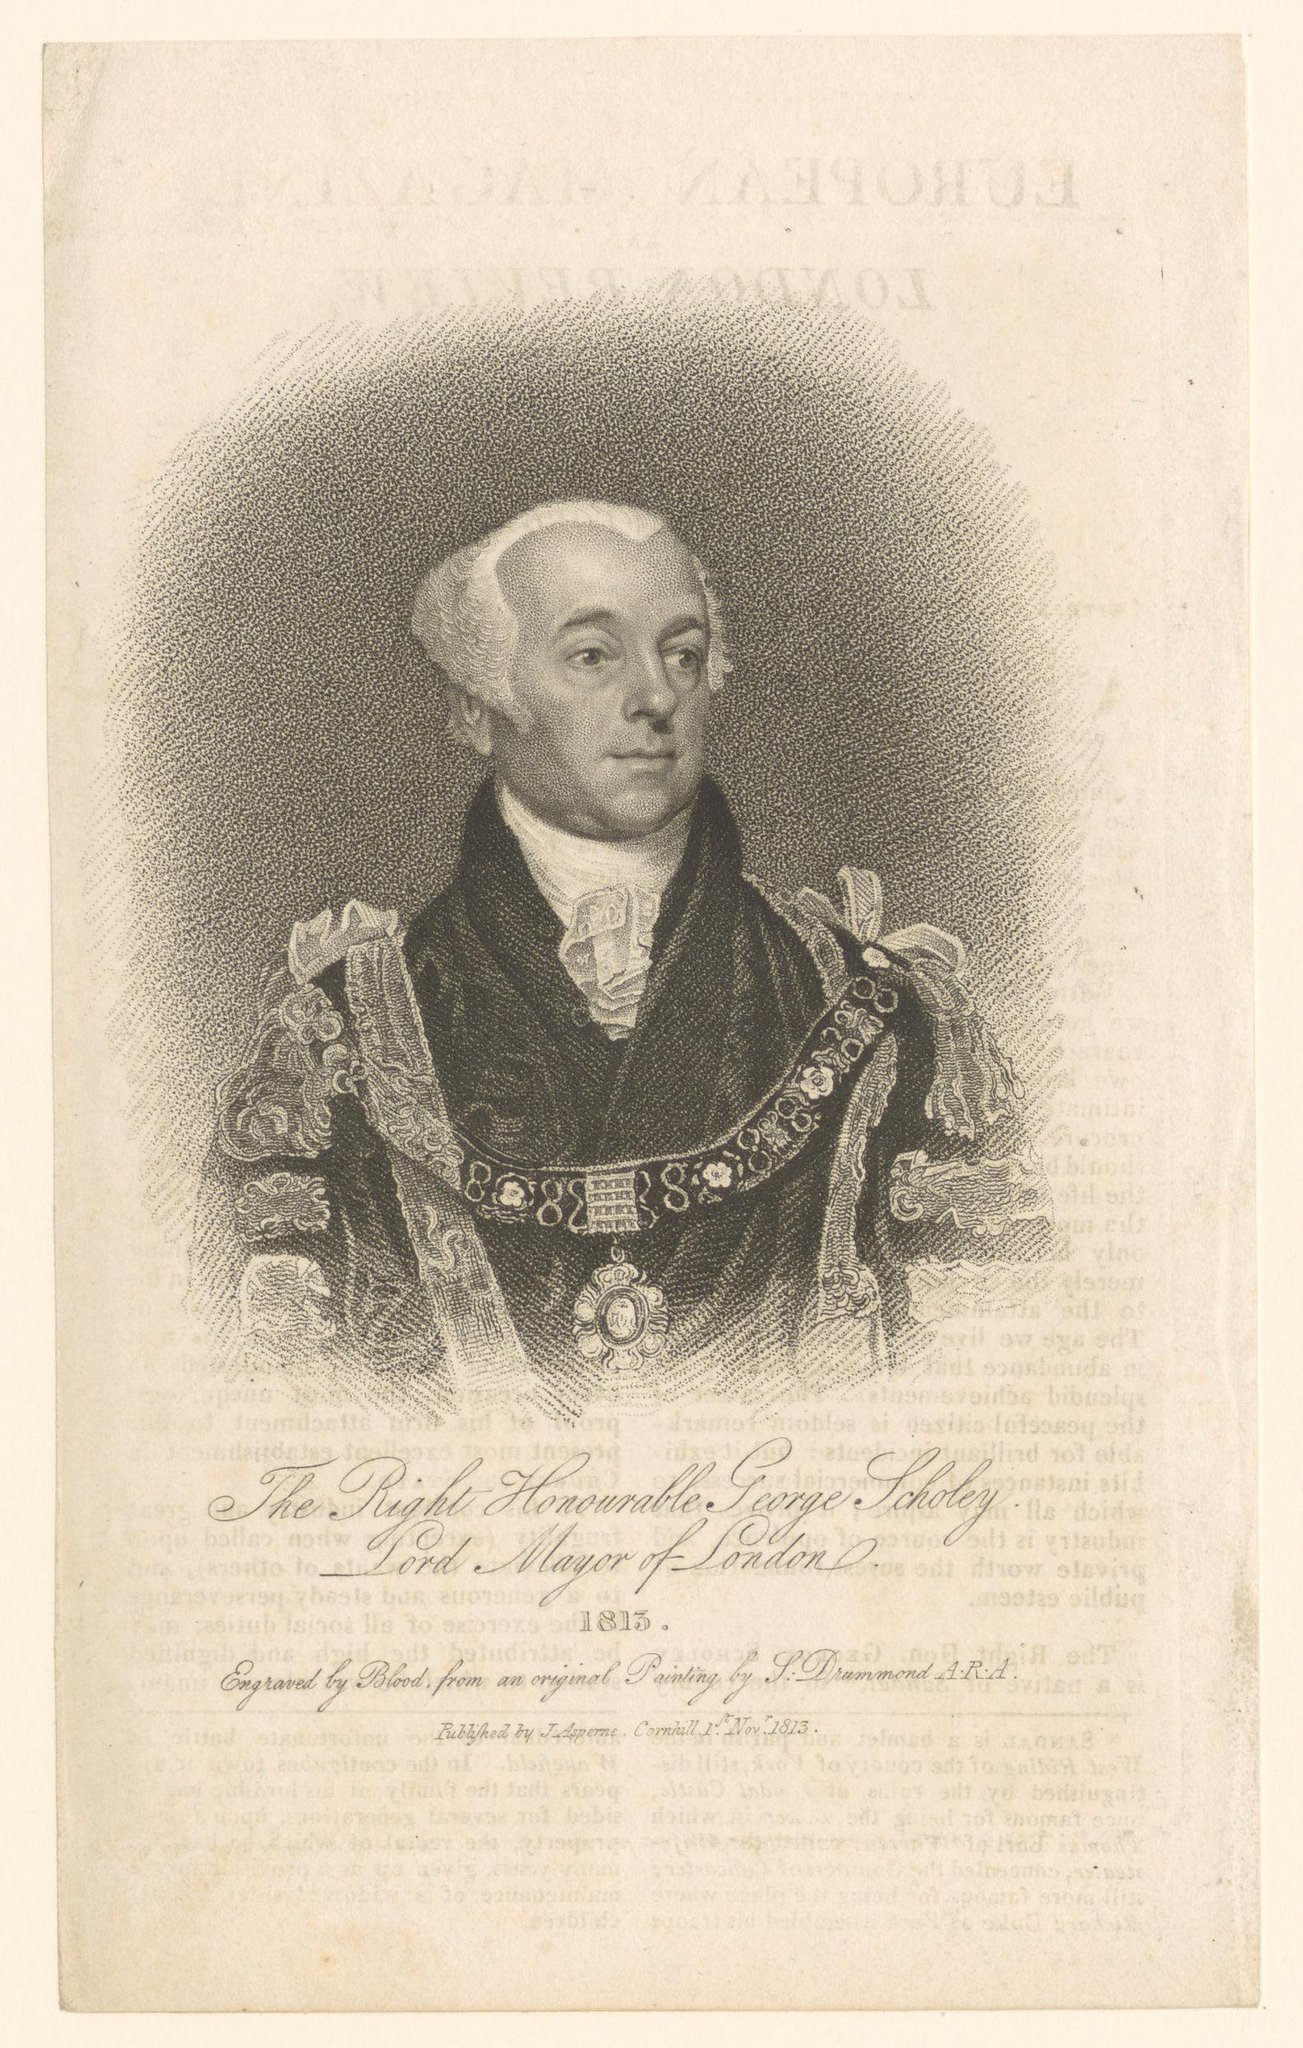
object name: print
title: The Right Honourable George Scholey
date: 1811-1813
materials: paper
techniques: engraving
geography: london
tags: mayor, burgomaster, banker, historical persons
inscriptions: collector's mark: Lugt 2228